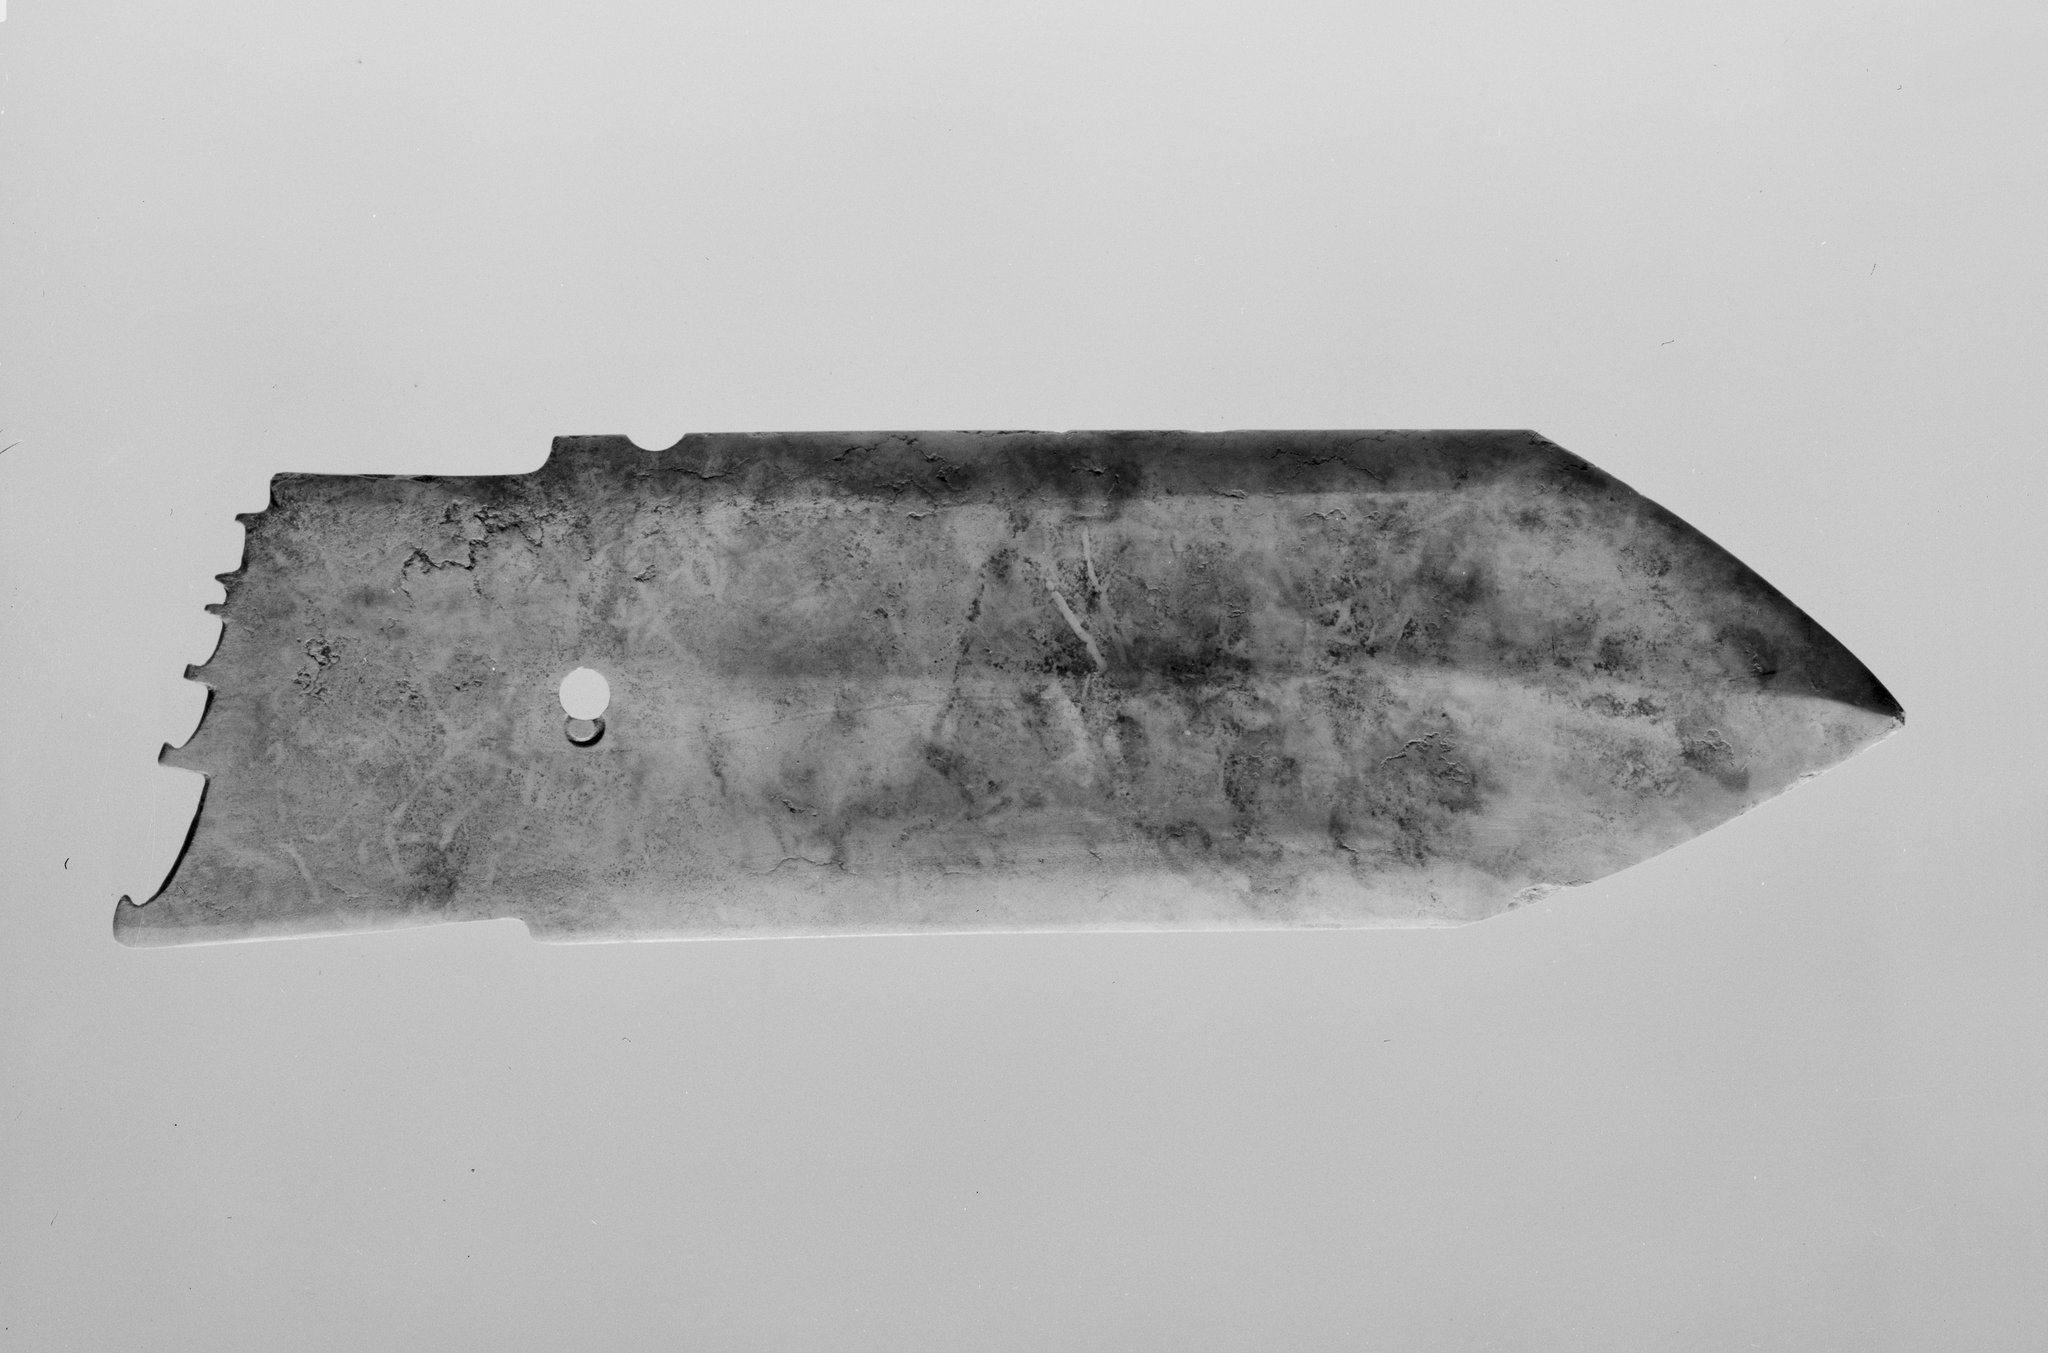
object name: dagger ax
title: Ceremonial dagger-ax (Ge)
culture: chinese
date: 1300-1001 BCE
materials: jade